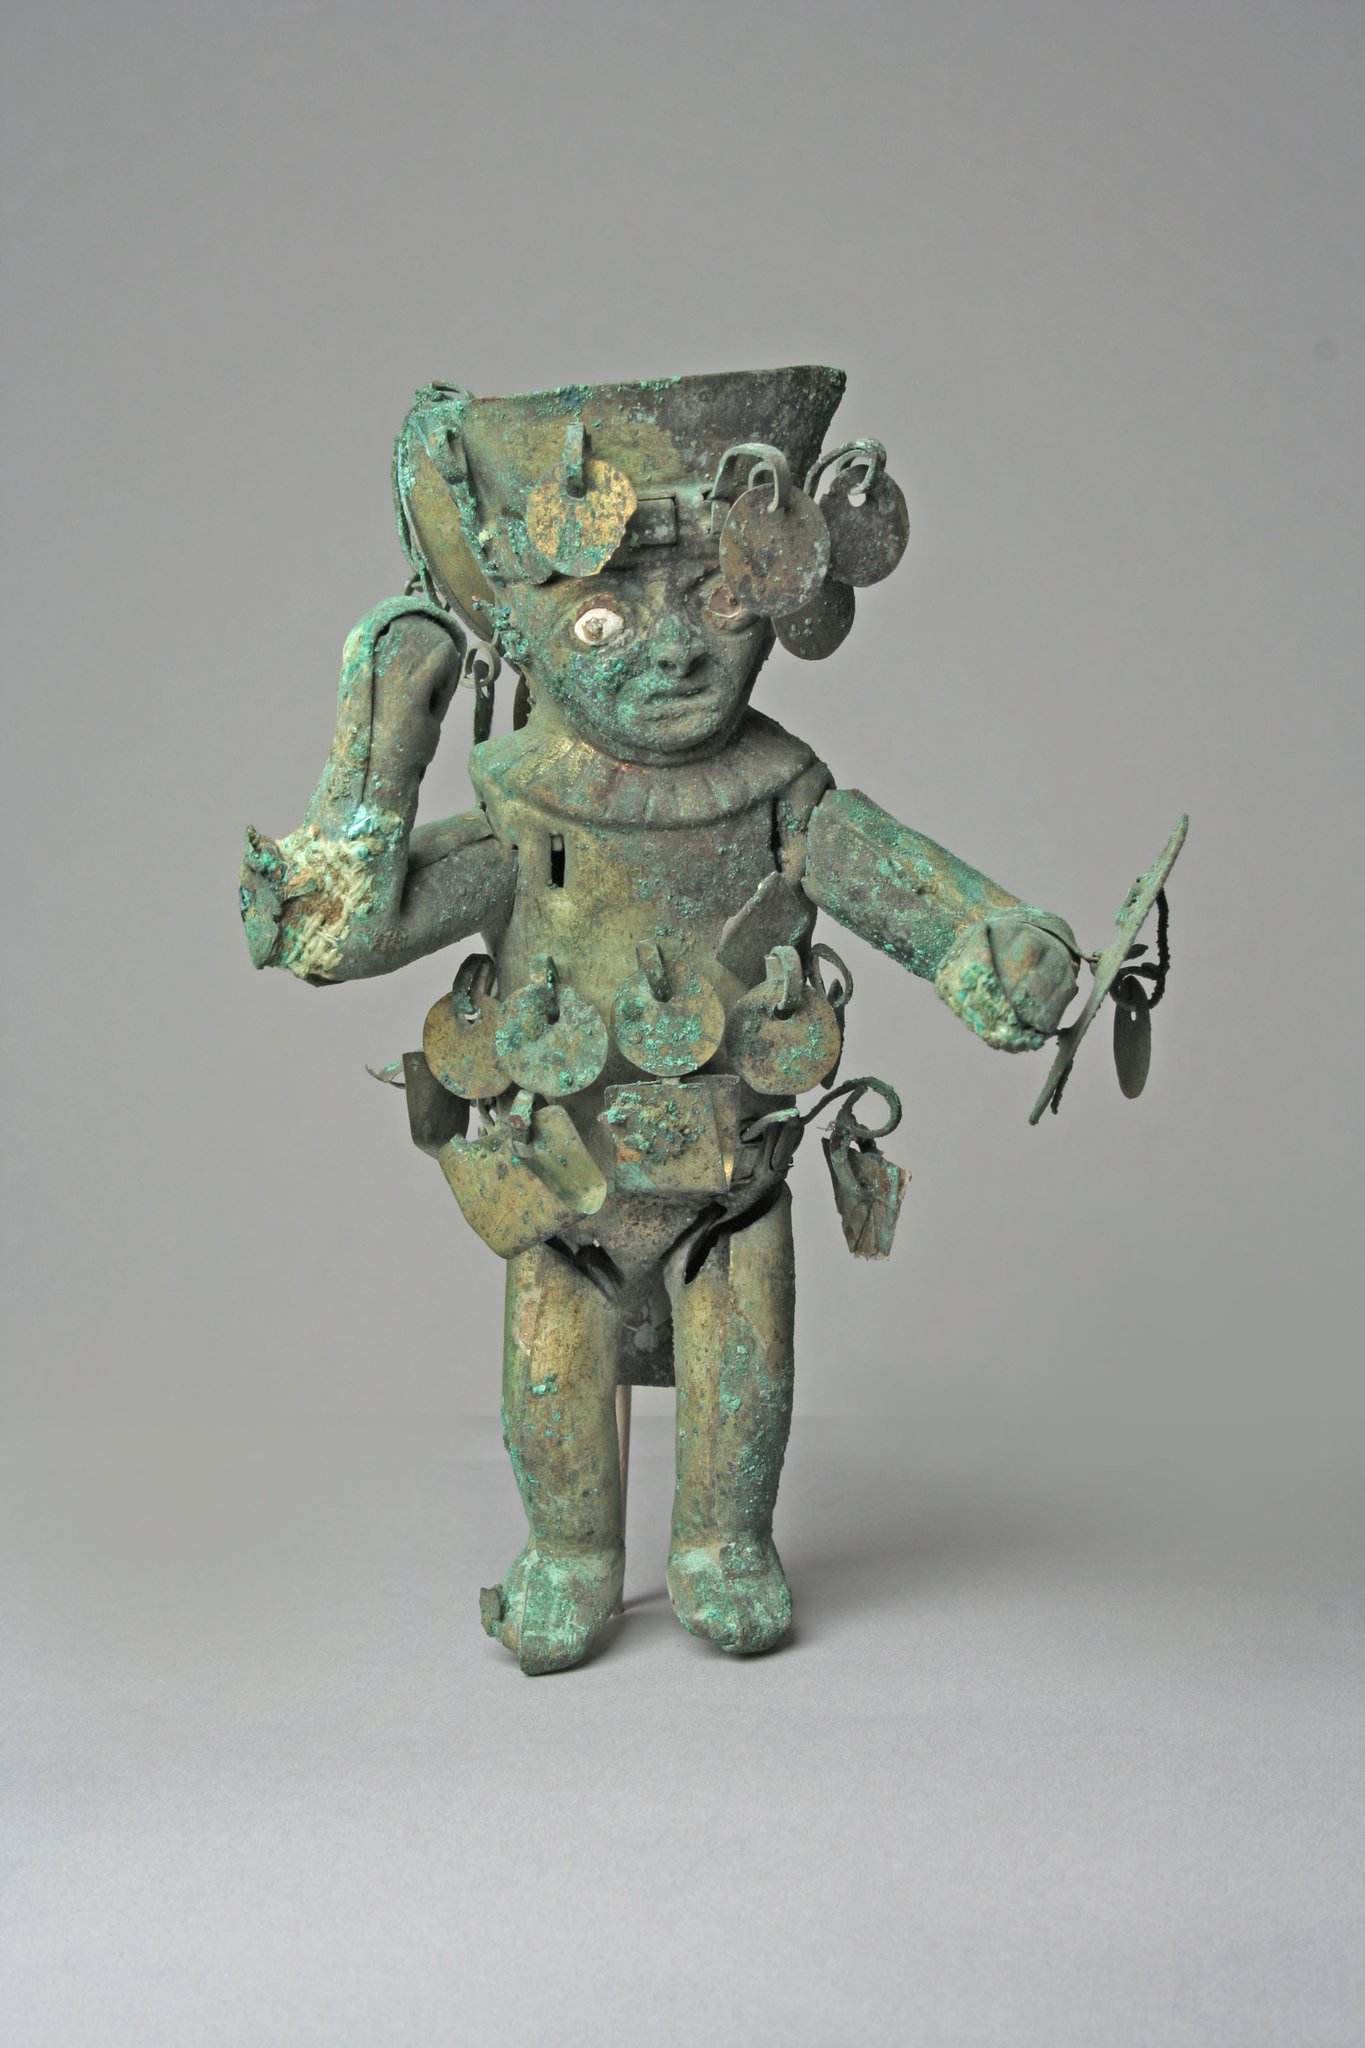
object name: ornament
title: Warrior figure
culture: moche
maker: moche artist(s)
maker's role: artist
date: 500-800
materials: gilt copper, shell, stone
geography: peru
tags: warriors